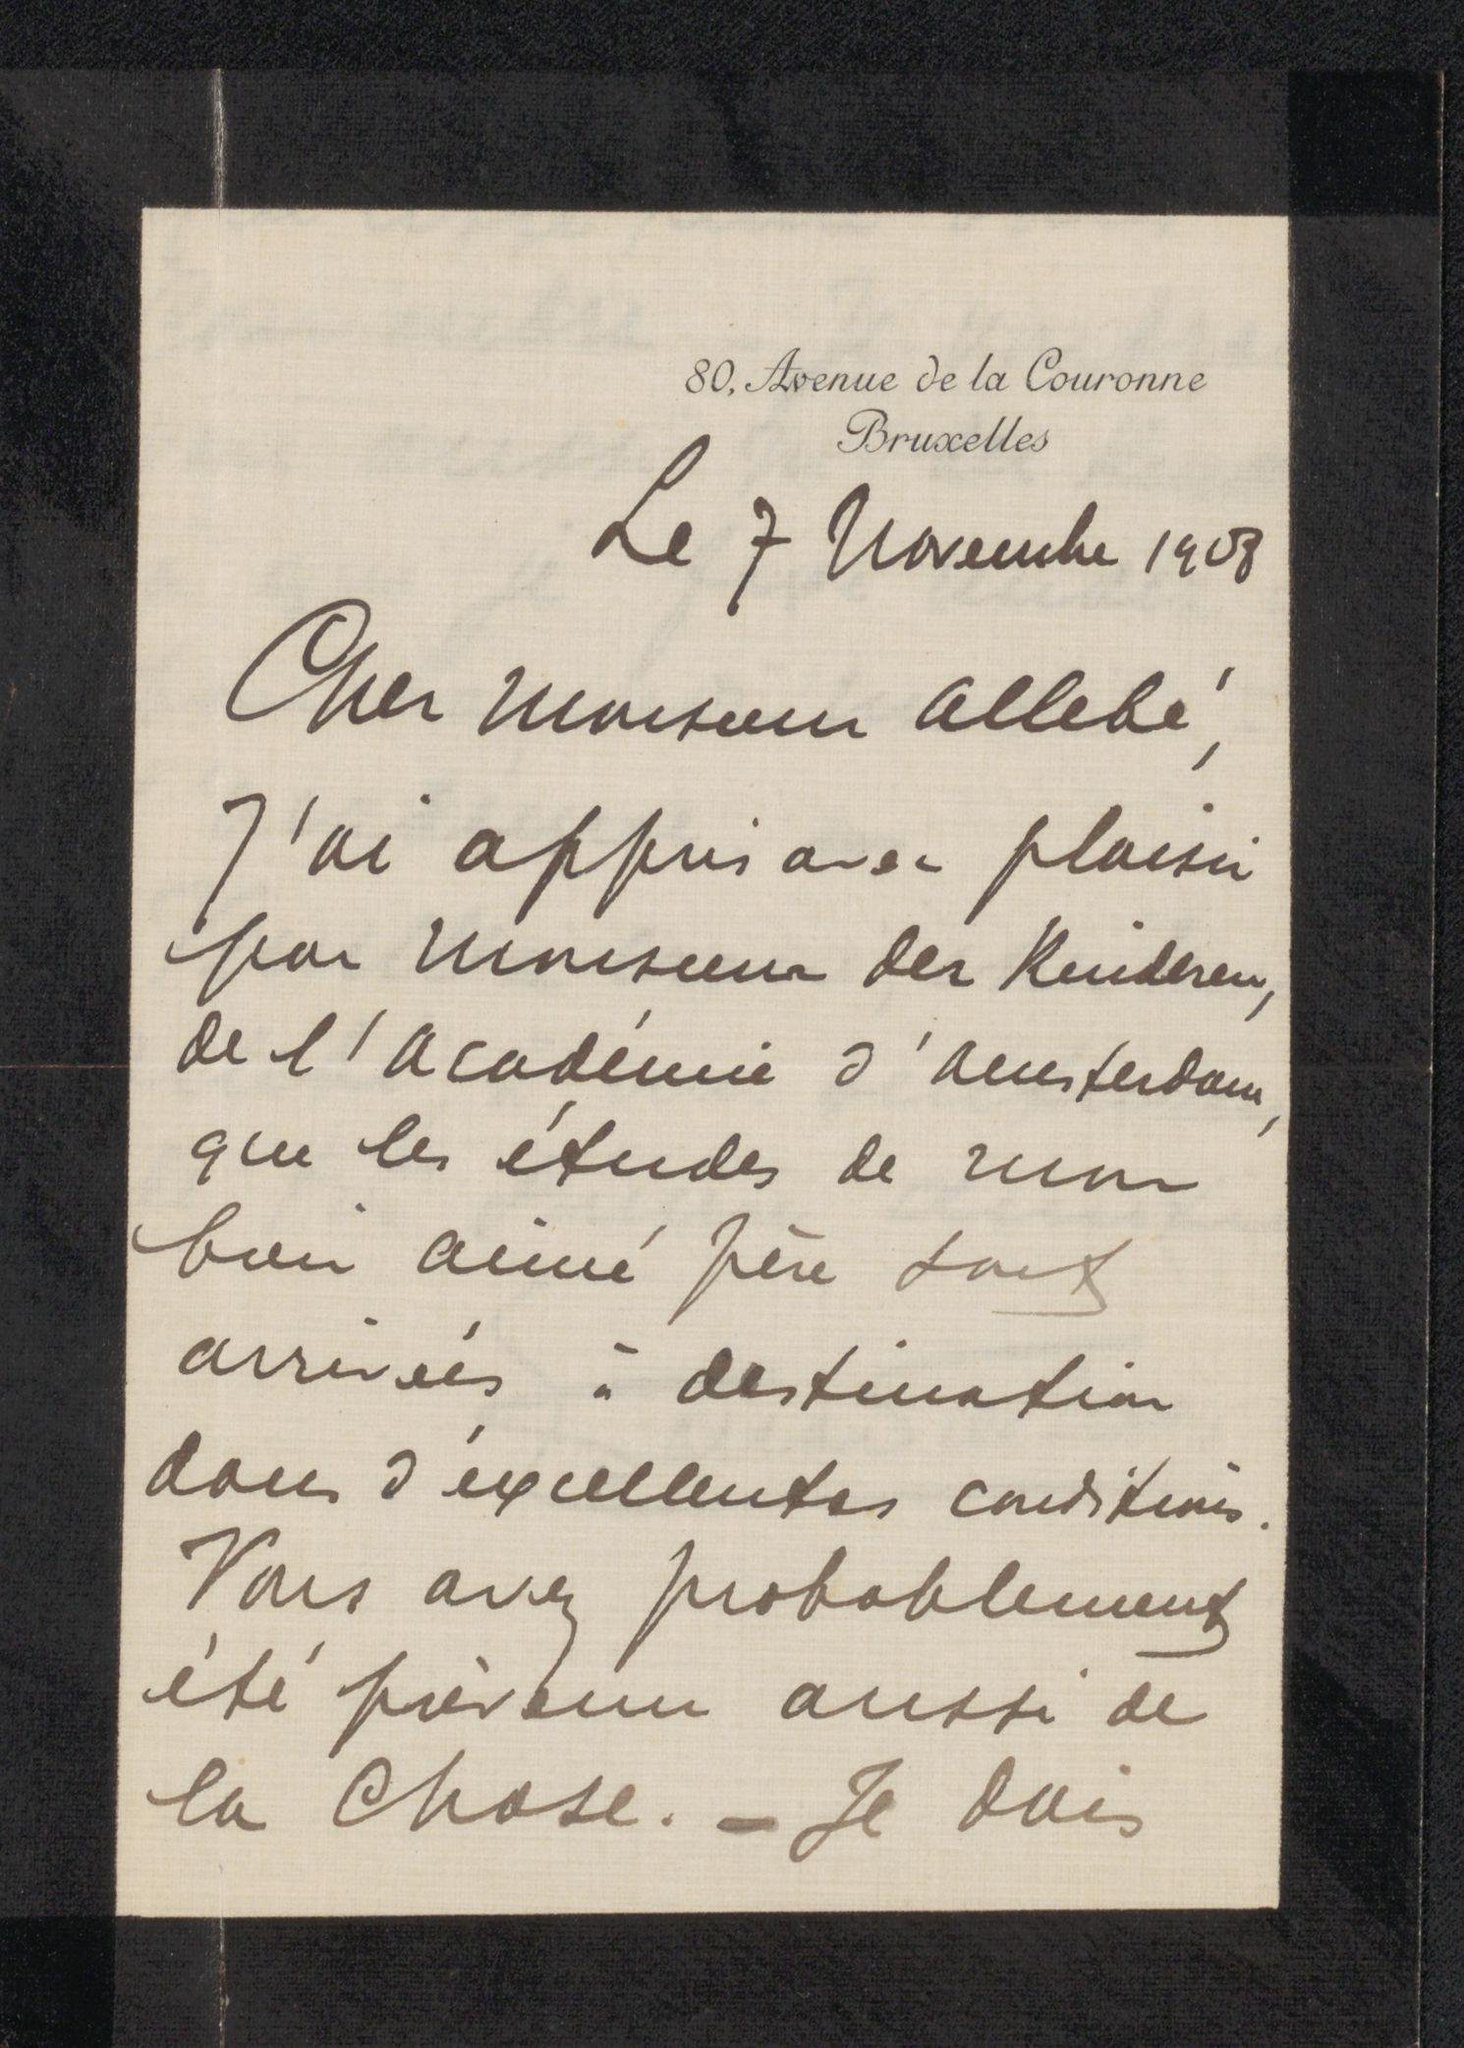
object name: letter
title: Brief aan August Allebé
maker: e. de haas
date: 1908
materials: ink, paper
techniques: pen, printing, writing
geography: brussels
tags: print maker, draughtsman, august allebé, painter, antoon derkinderen, amsterdam